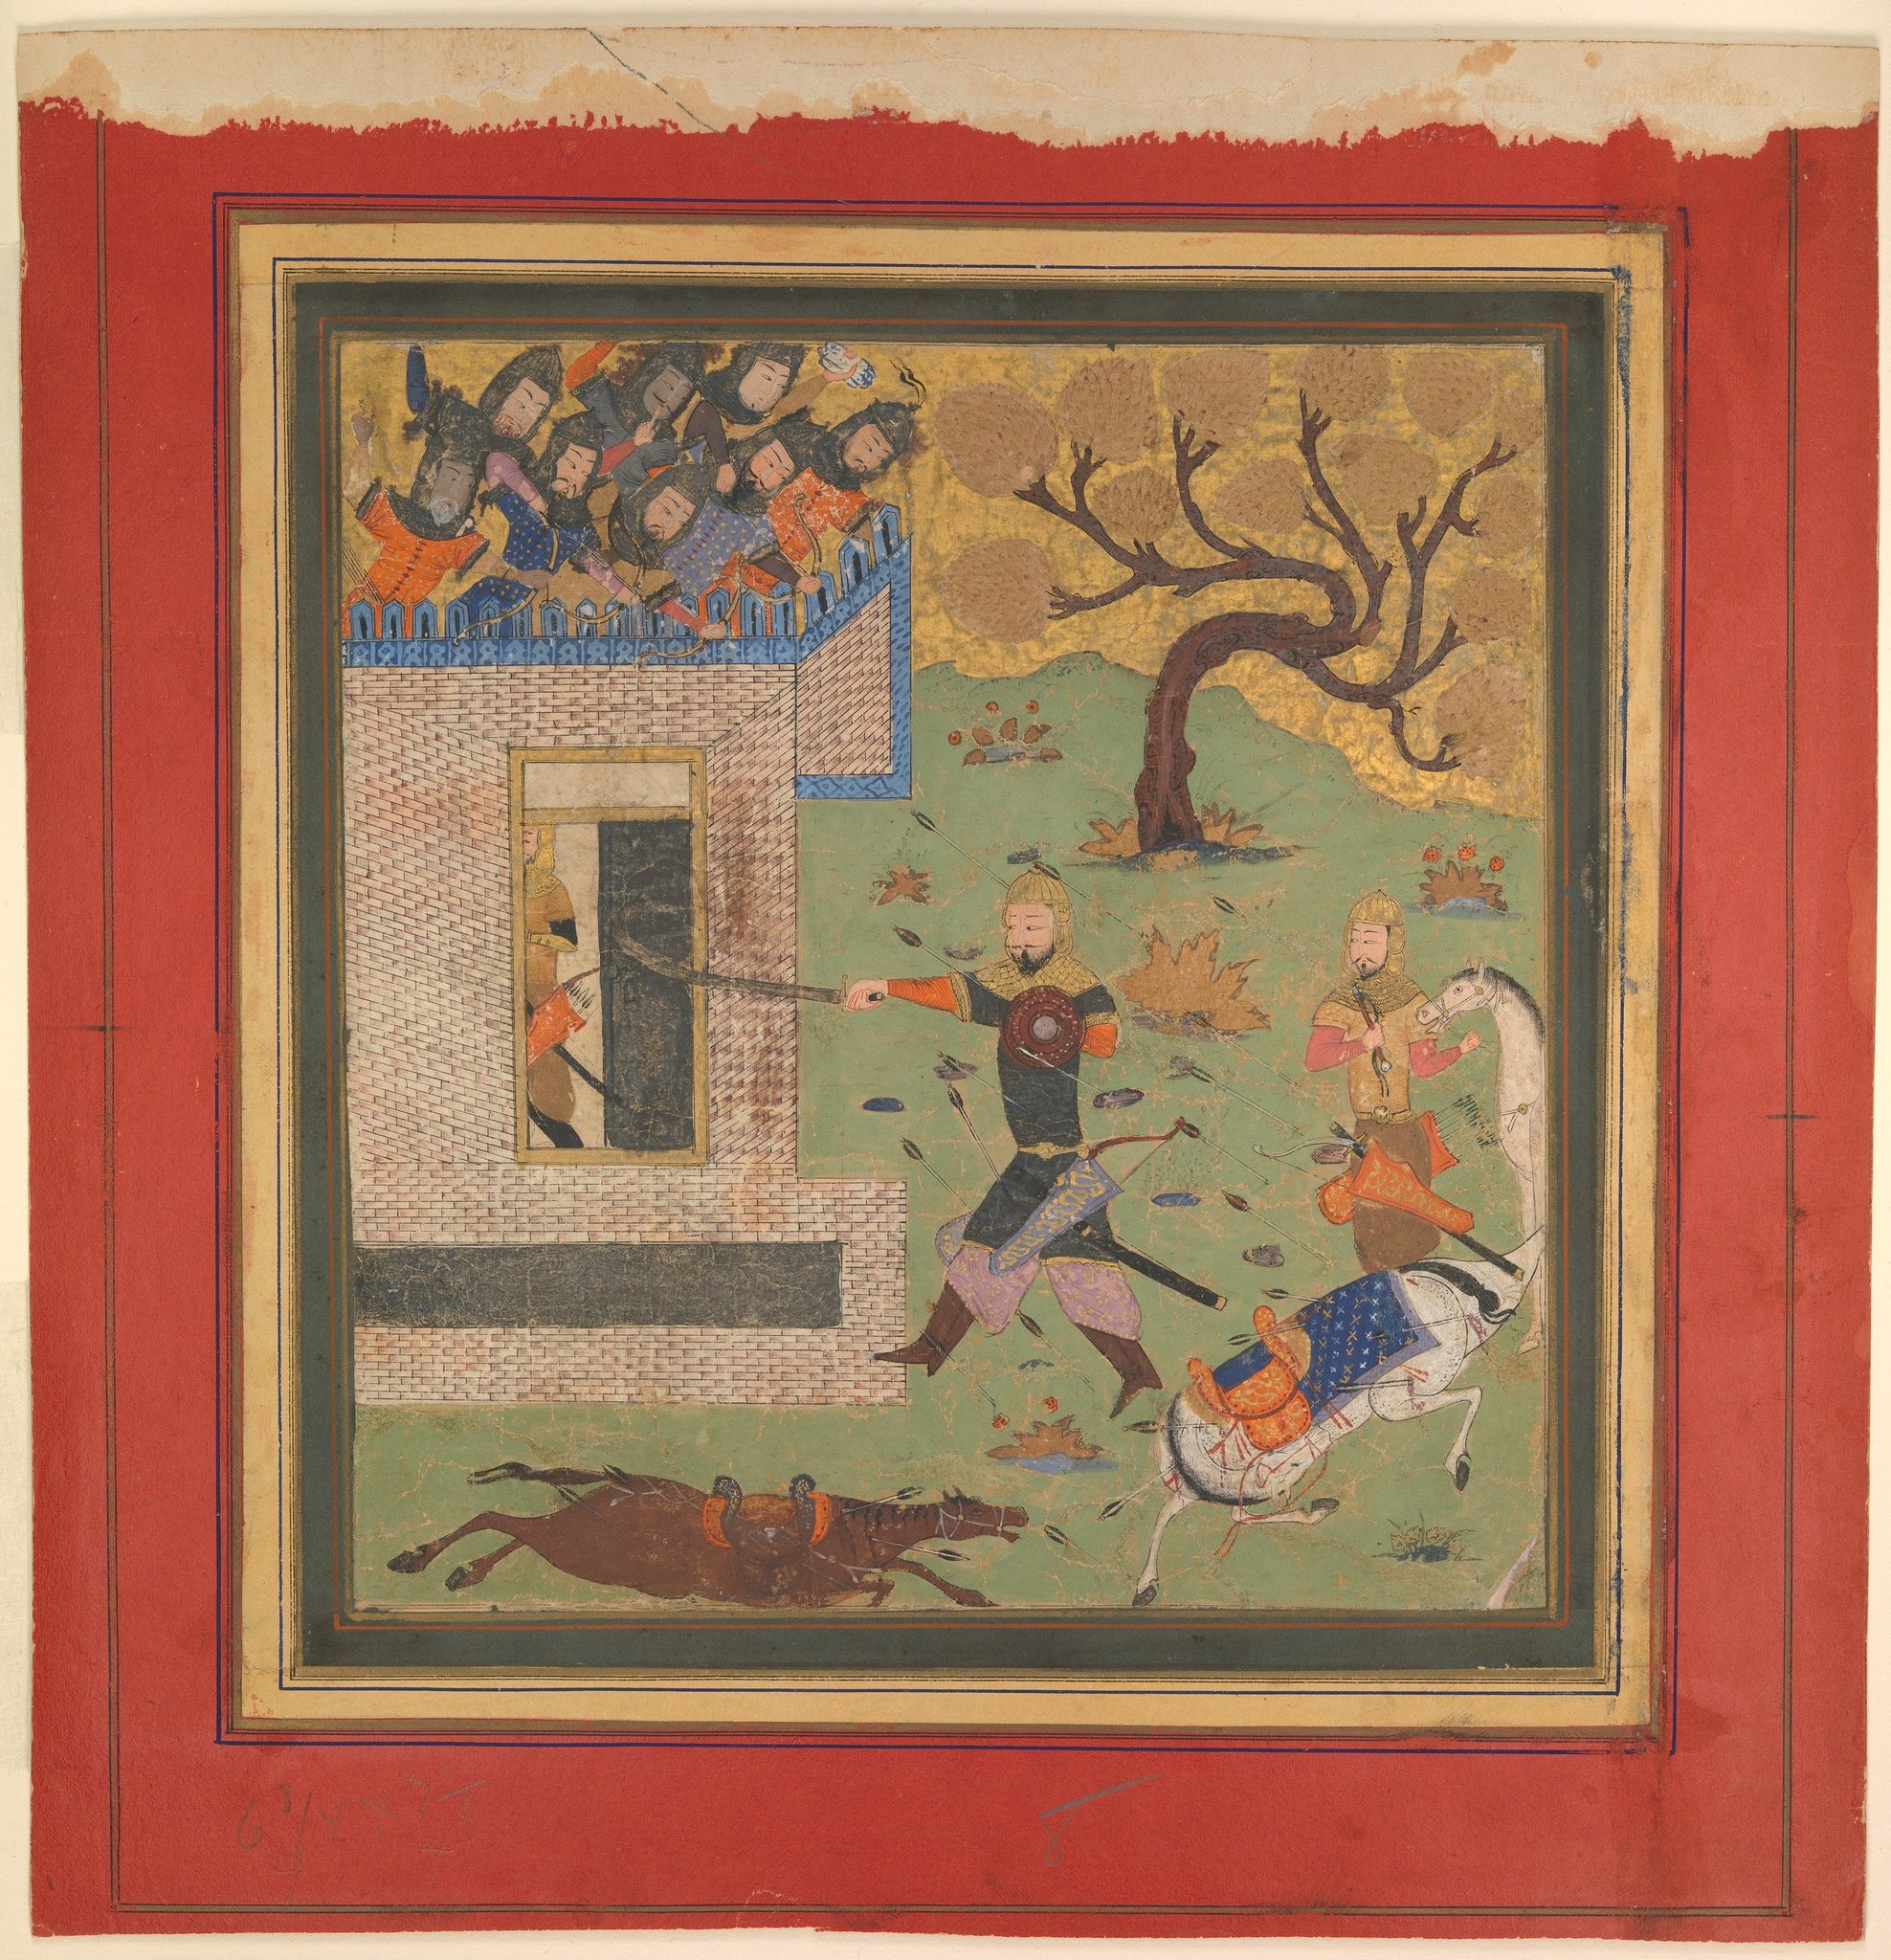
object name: folio from an illustrated manuscript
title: "Bizhan Forces Farud to Retreat into his Fort", Folio from a Shahnama (Book of Kings)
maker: abu'l qasim firdausi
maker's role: author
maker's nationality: iranian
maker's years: 935-1020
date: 1430-1440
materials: gold, ink, paper, watercolor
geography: india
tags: soldiers,arrows,men,horses,warriors